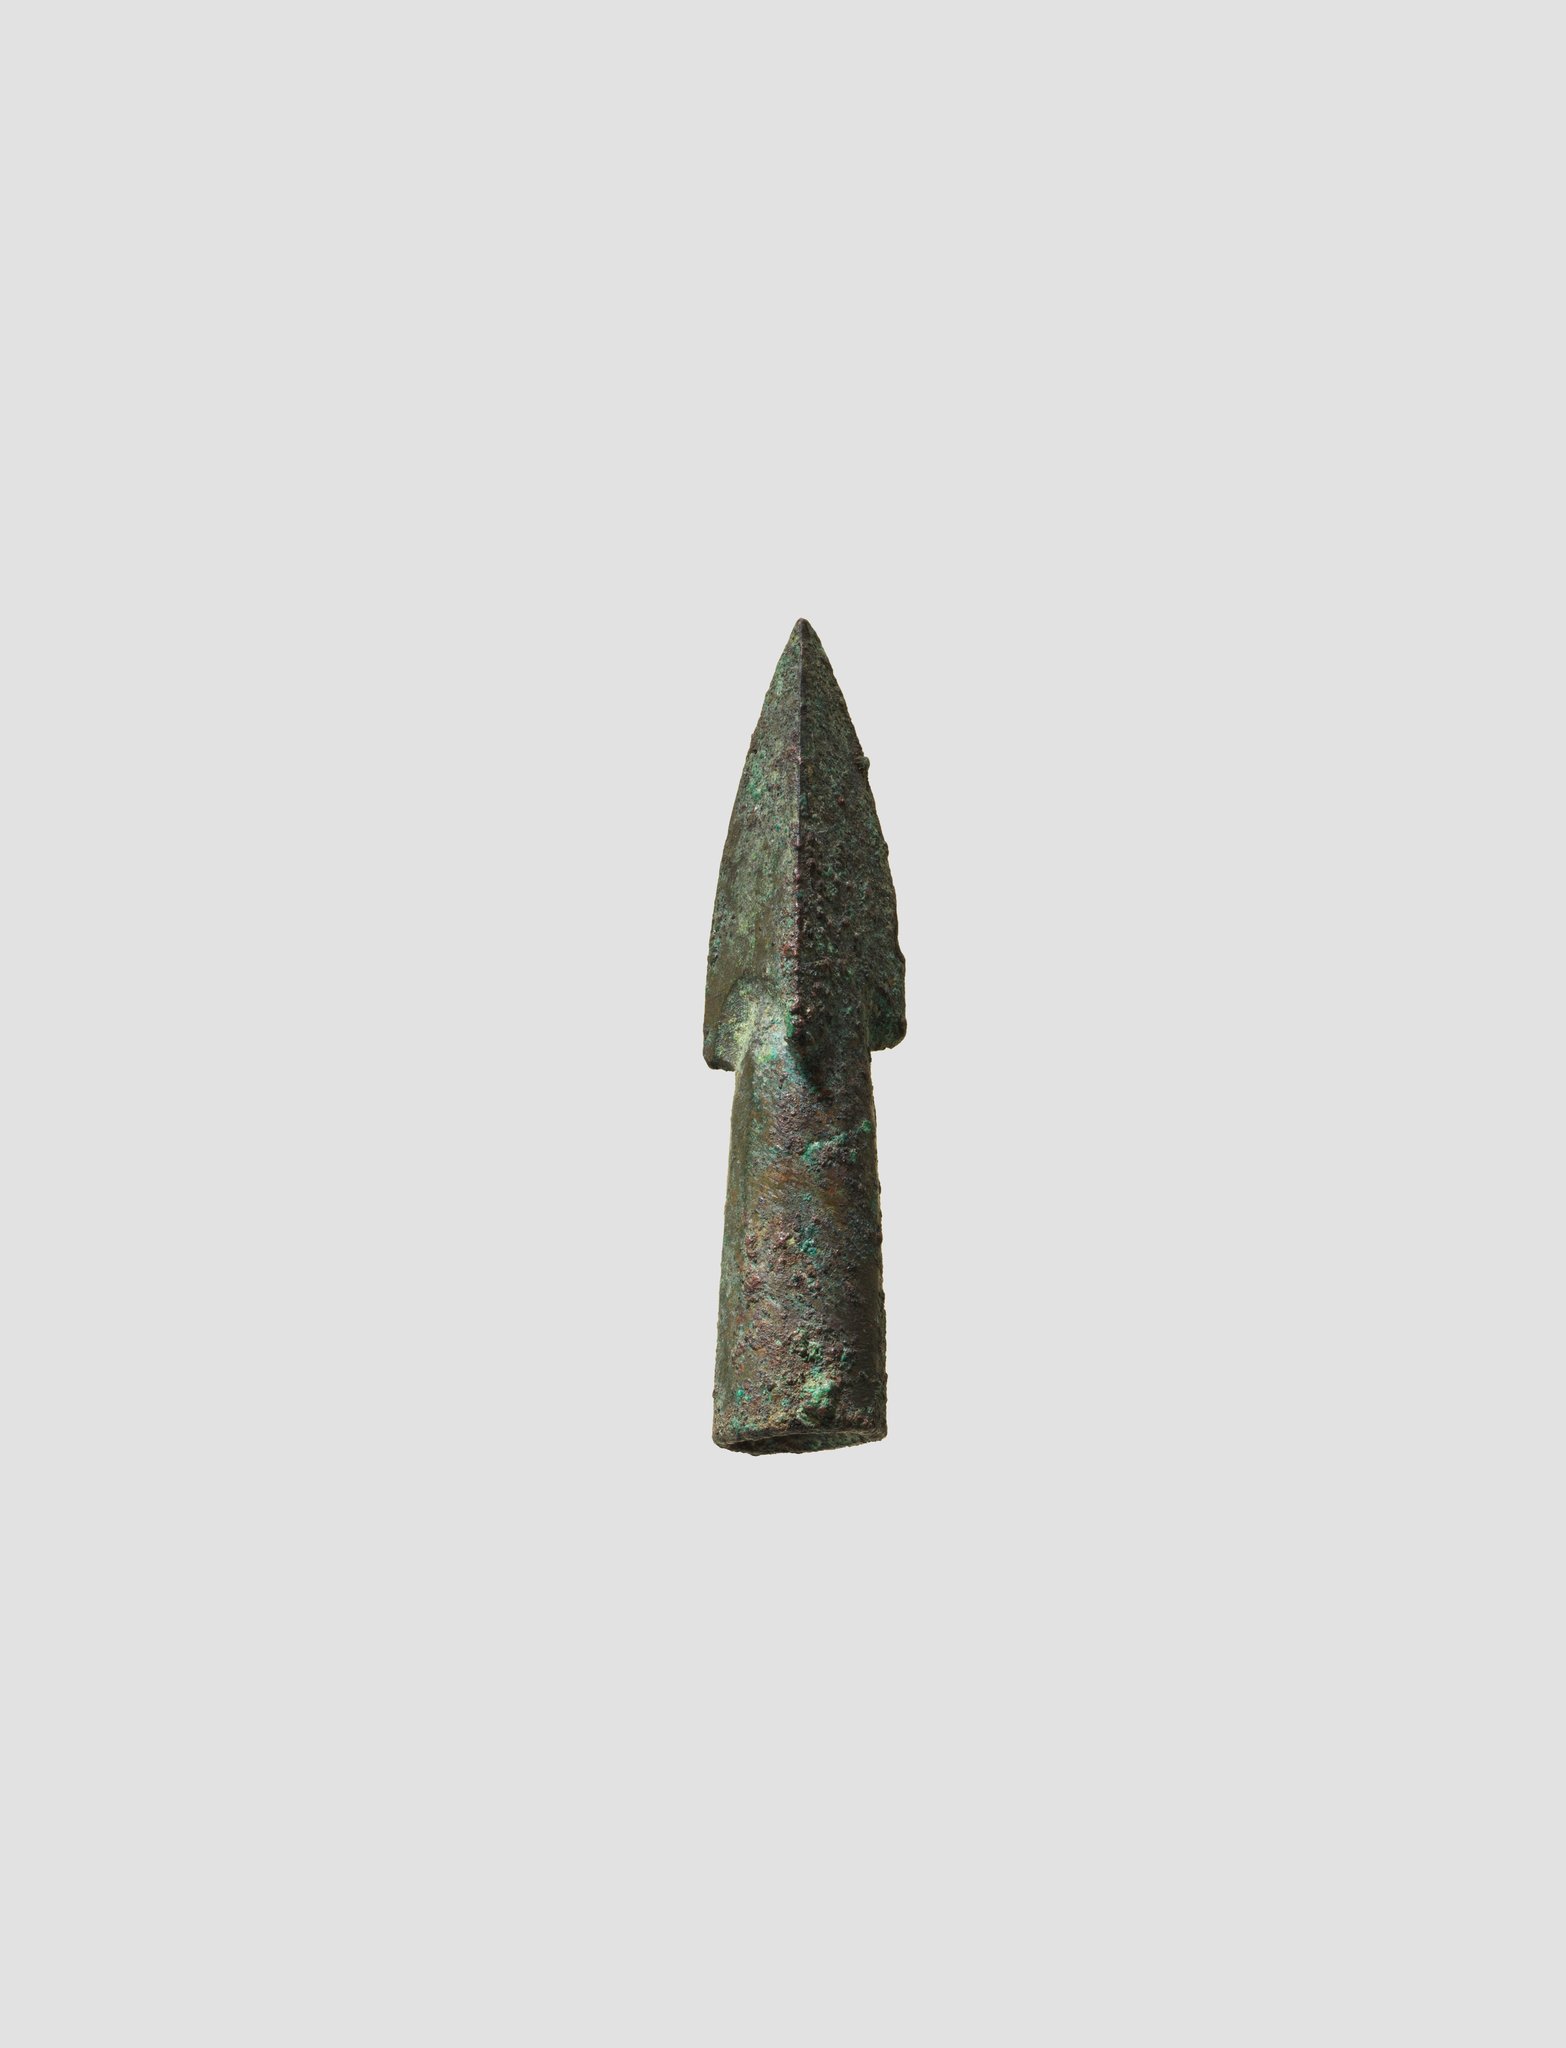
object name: arrowhead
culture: iranian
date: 601-700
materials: bronze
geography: iran